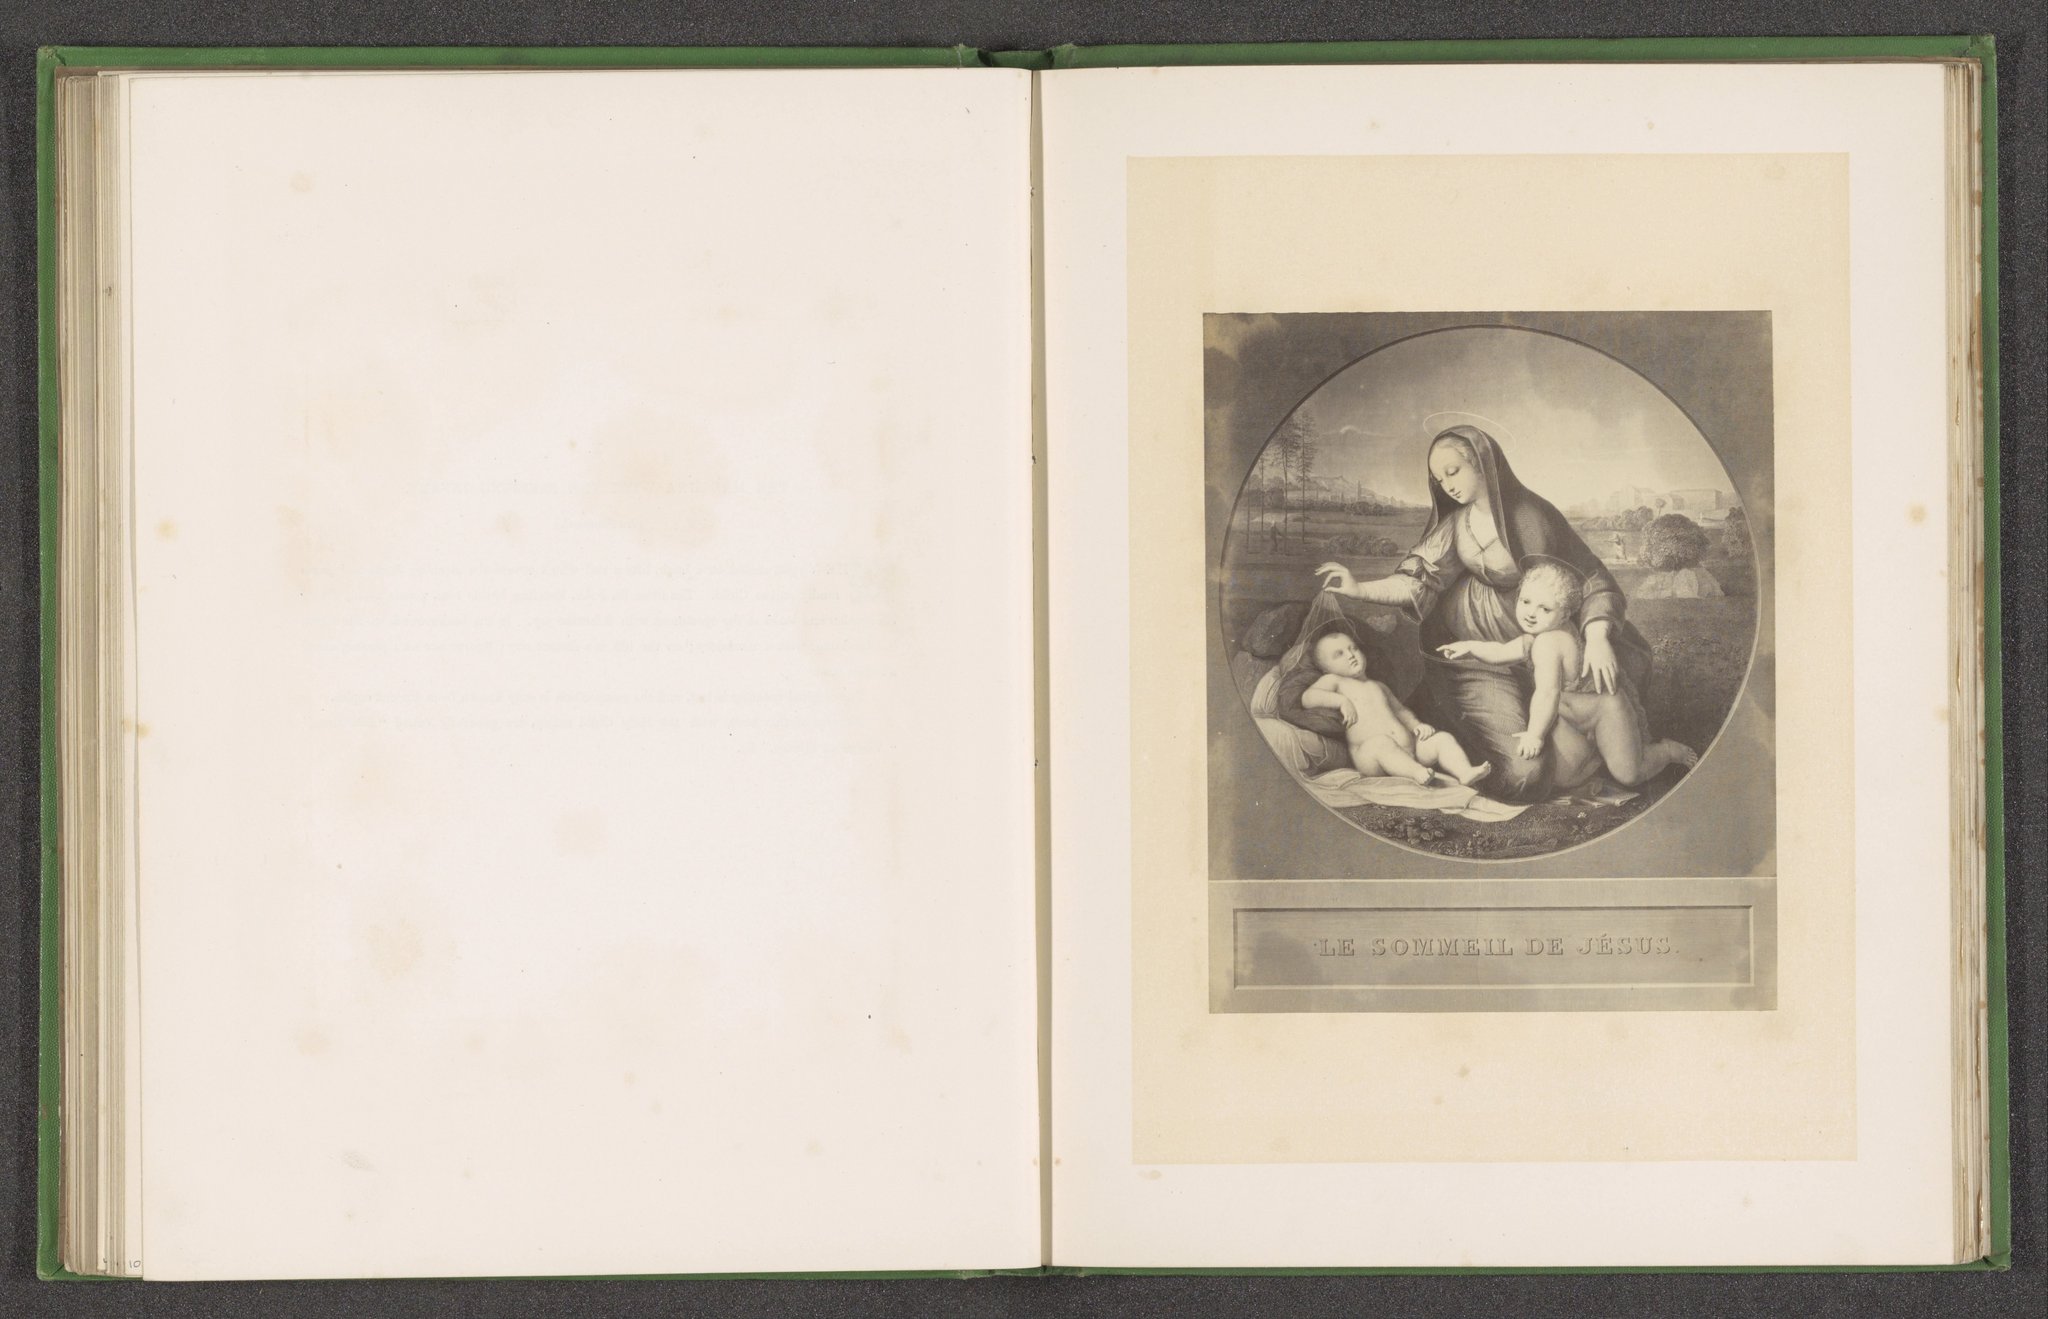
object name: page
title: Fotoreproductie van een prent door vermoedelijk Achille Louis Martinet van de Madonna del Silenzio door Rafaël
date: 1859-1869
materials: photographic support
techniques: albumen print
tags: madonna: i.e. mary with the christ-child, series of scenes from the life of john the baptist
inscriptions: inscription: ‘Le Sommeil de Jésus.’